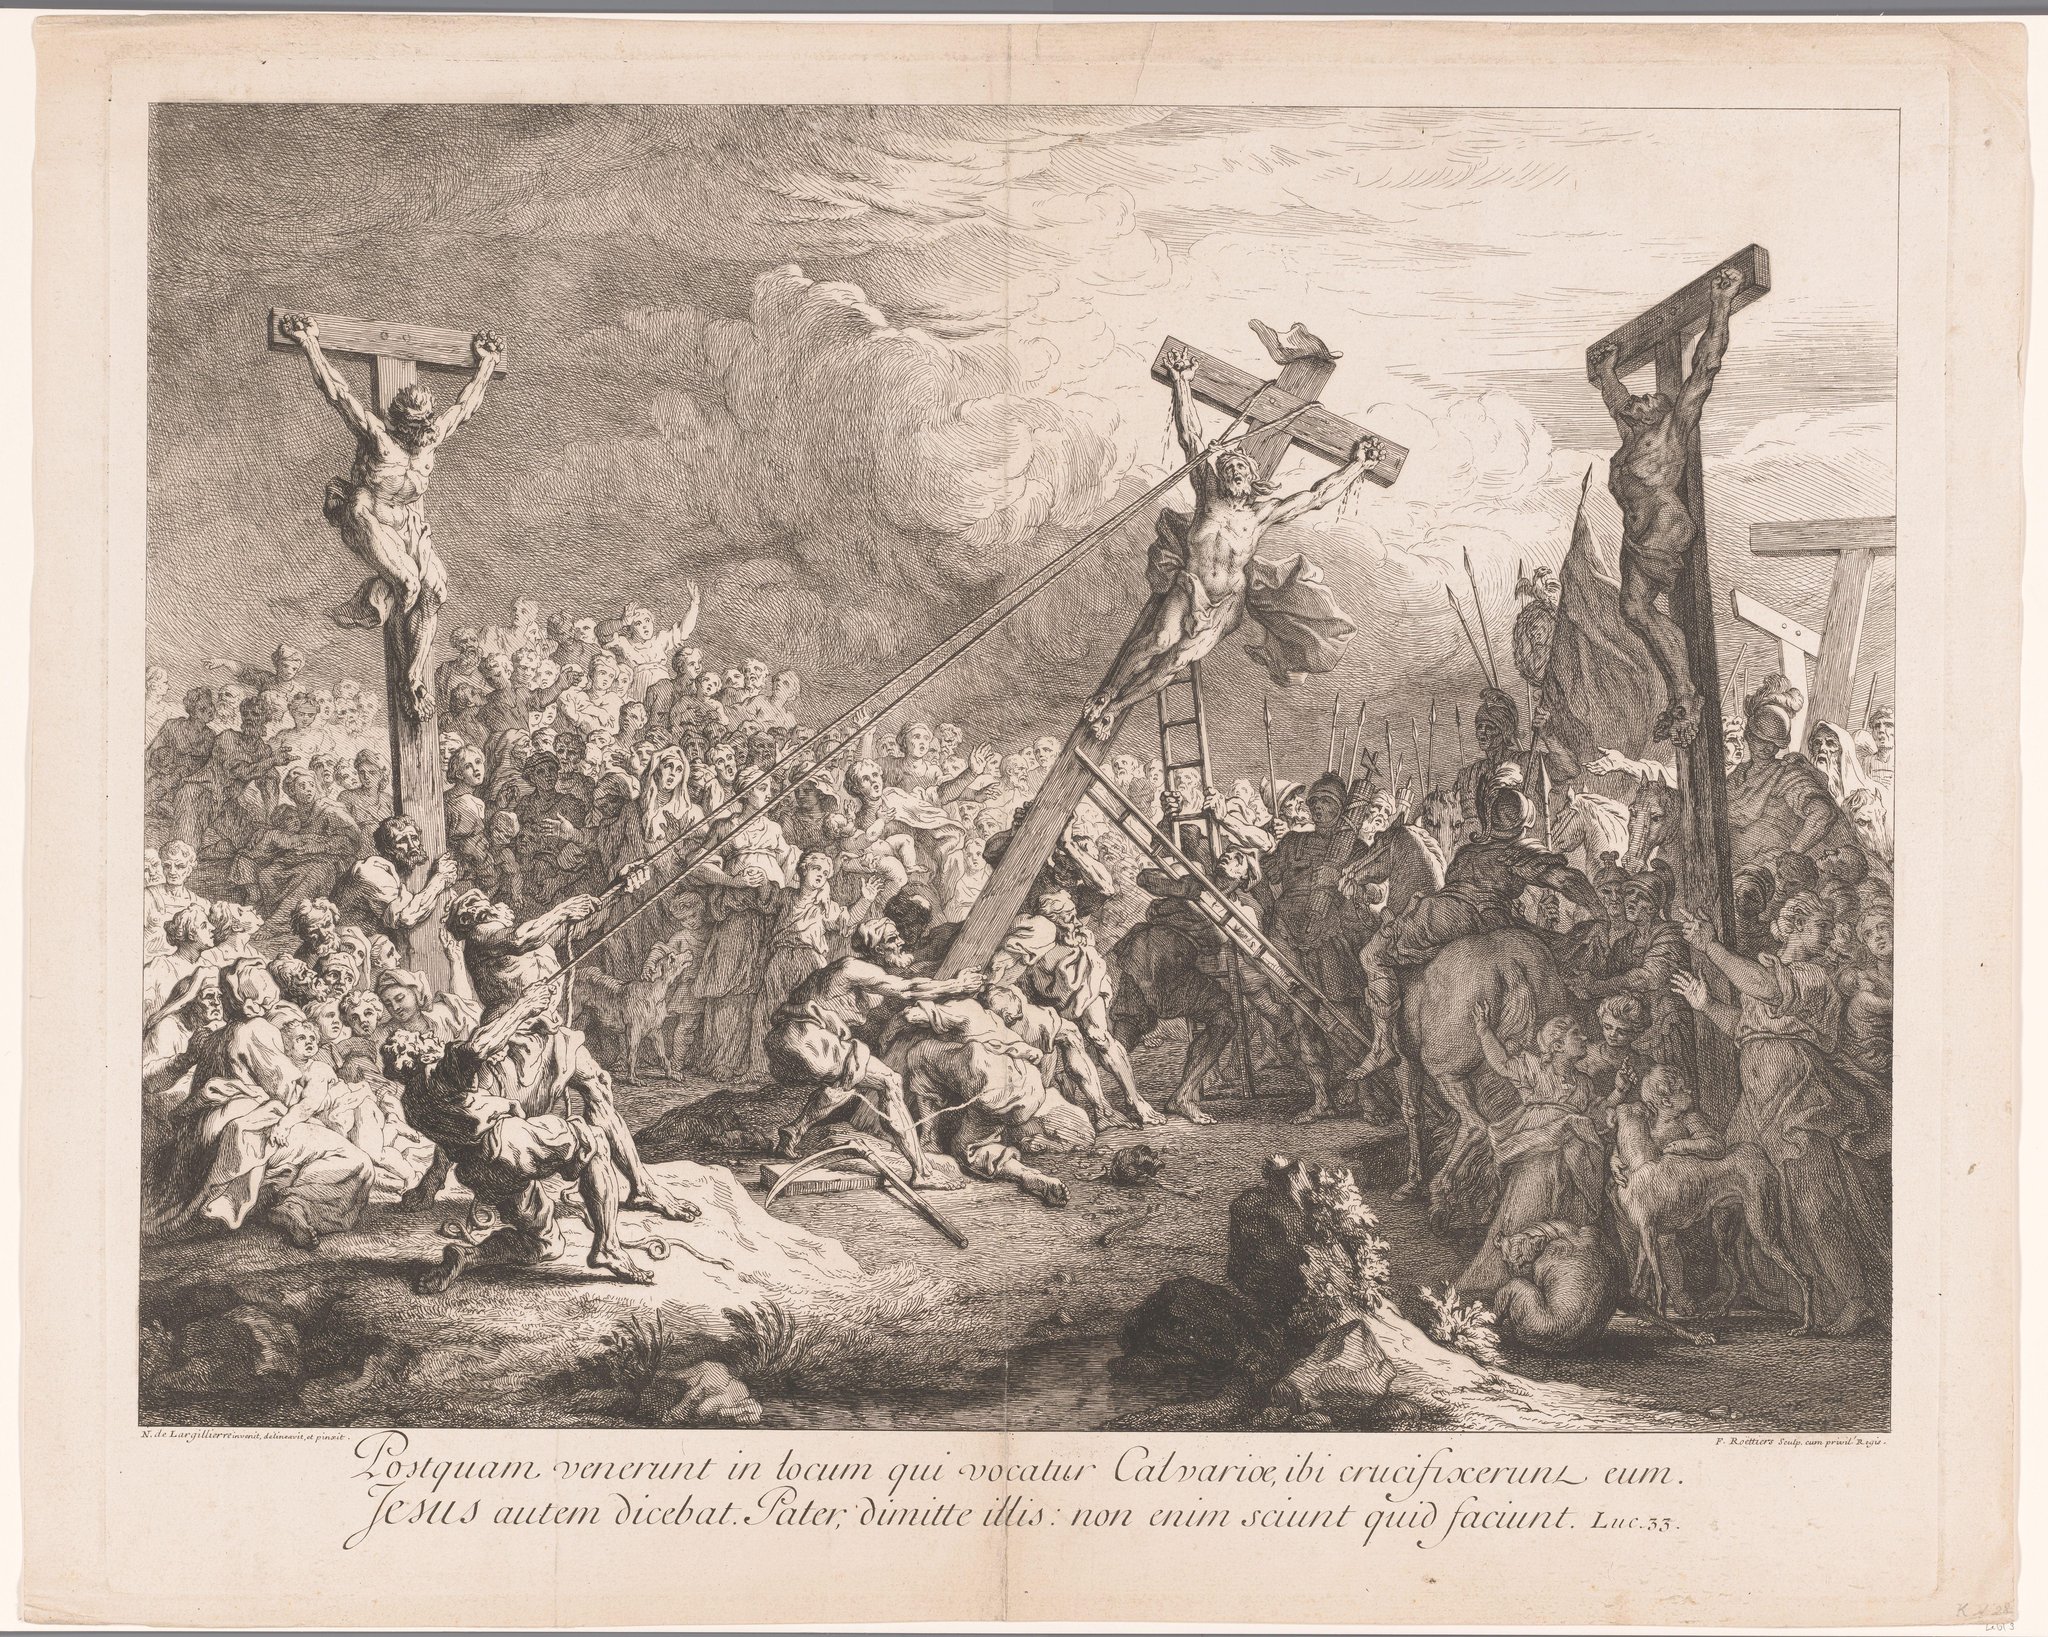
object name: print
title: Kruisoprichting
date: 1717-1770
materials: paper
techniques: etching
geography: france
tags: raising of the cross to which christ is nailed already - dd - three crosses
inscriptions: collector's mark: Lugt 240